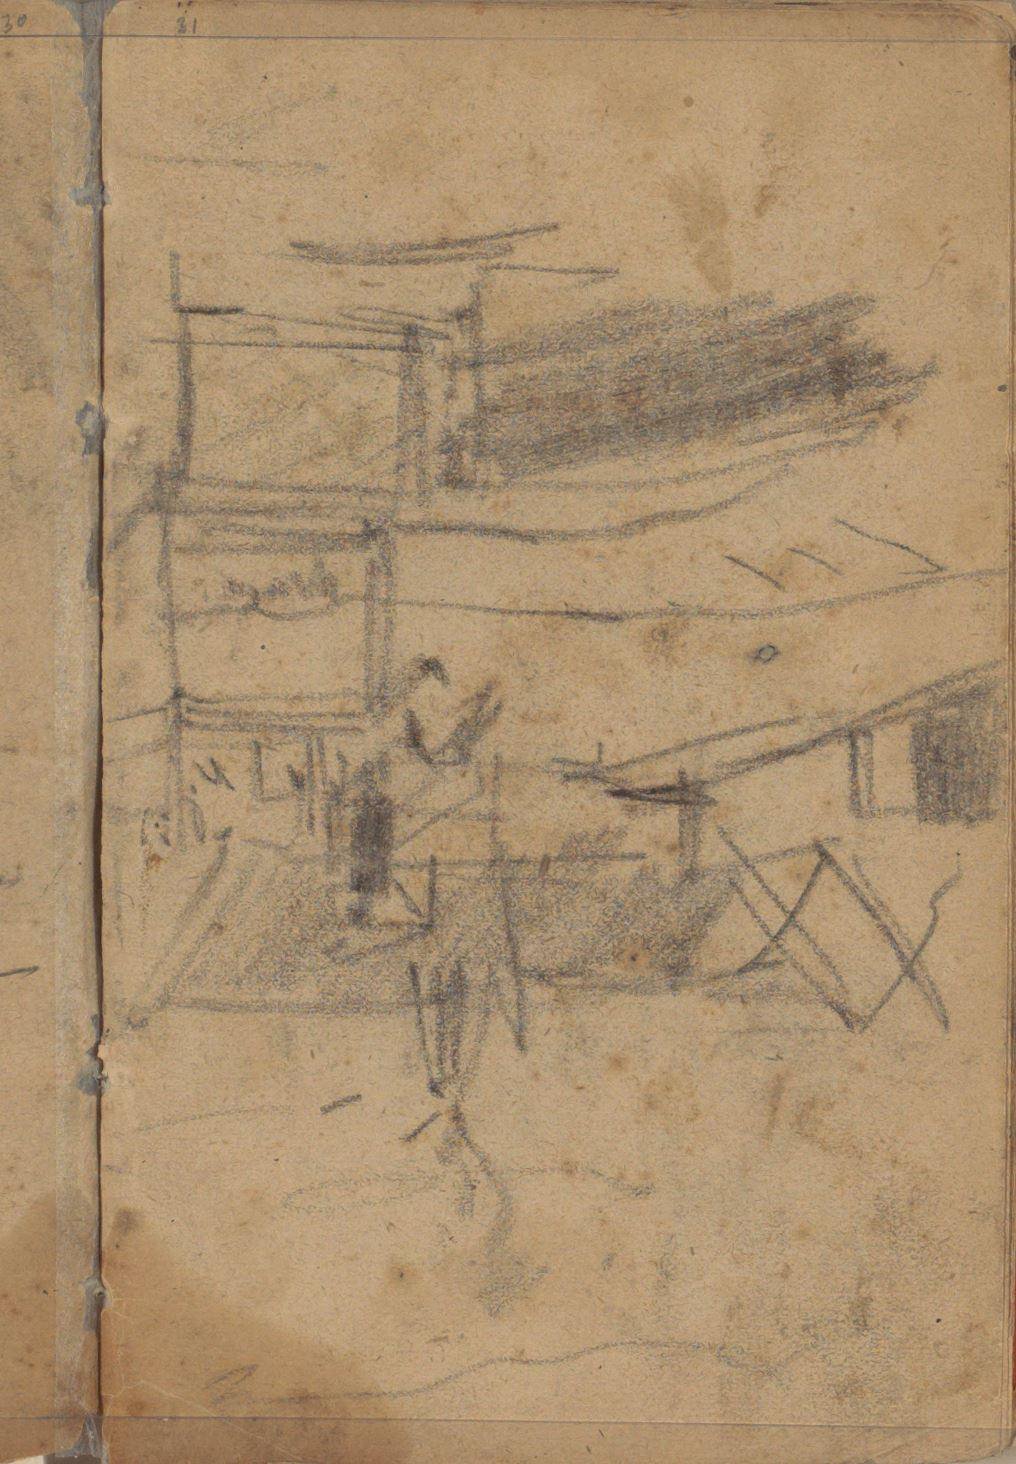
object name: sketchbook leaf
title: Gezicht op een gebouw, mogelijk een boerderij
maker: george hendrik breitner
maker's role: draughtsman, painter, print maker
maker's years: 1857-1923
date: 1881-1883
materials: chalk, paper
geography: south holland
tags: civic architecture; edifices; dwellings, farm (building)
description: Gezicht op een gebouw, mogelijk een boerderij. Pagina 31 uit een schetsboek met 70 bladen.